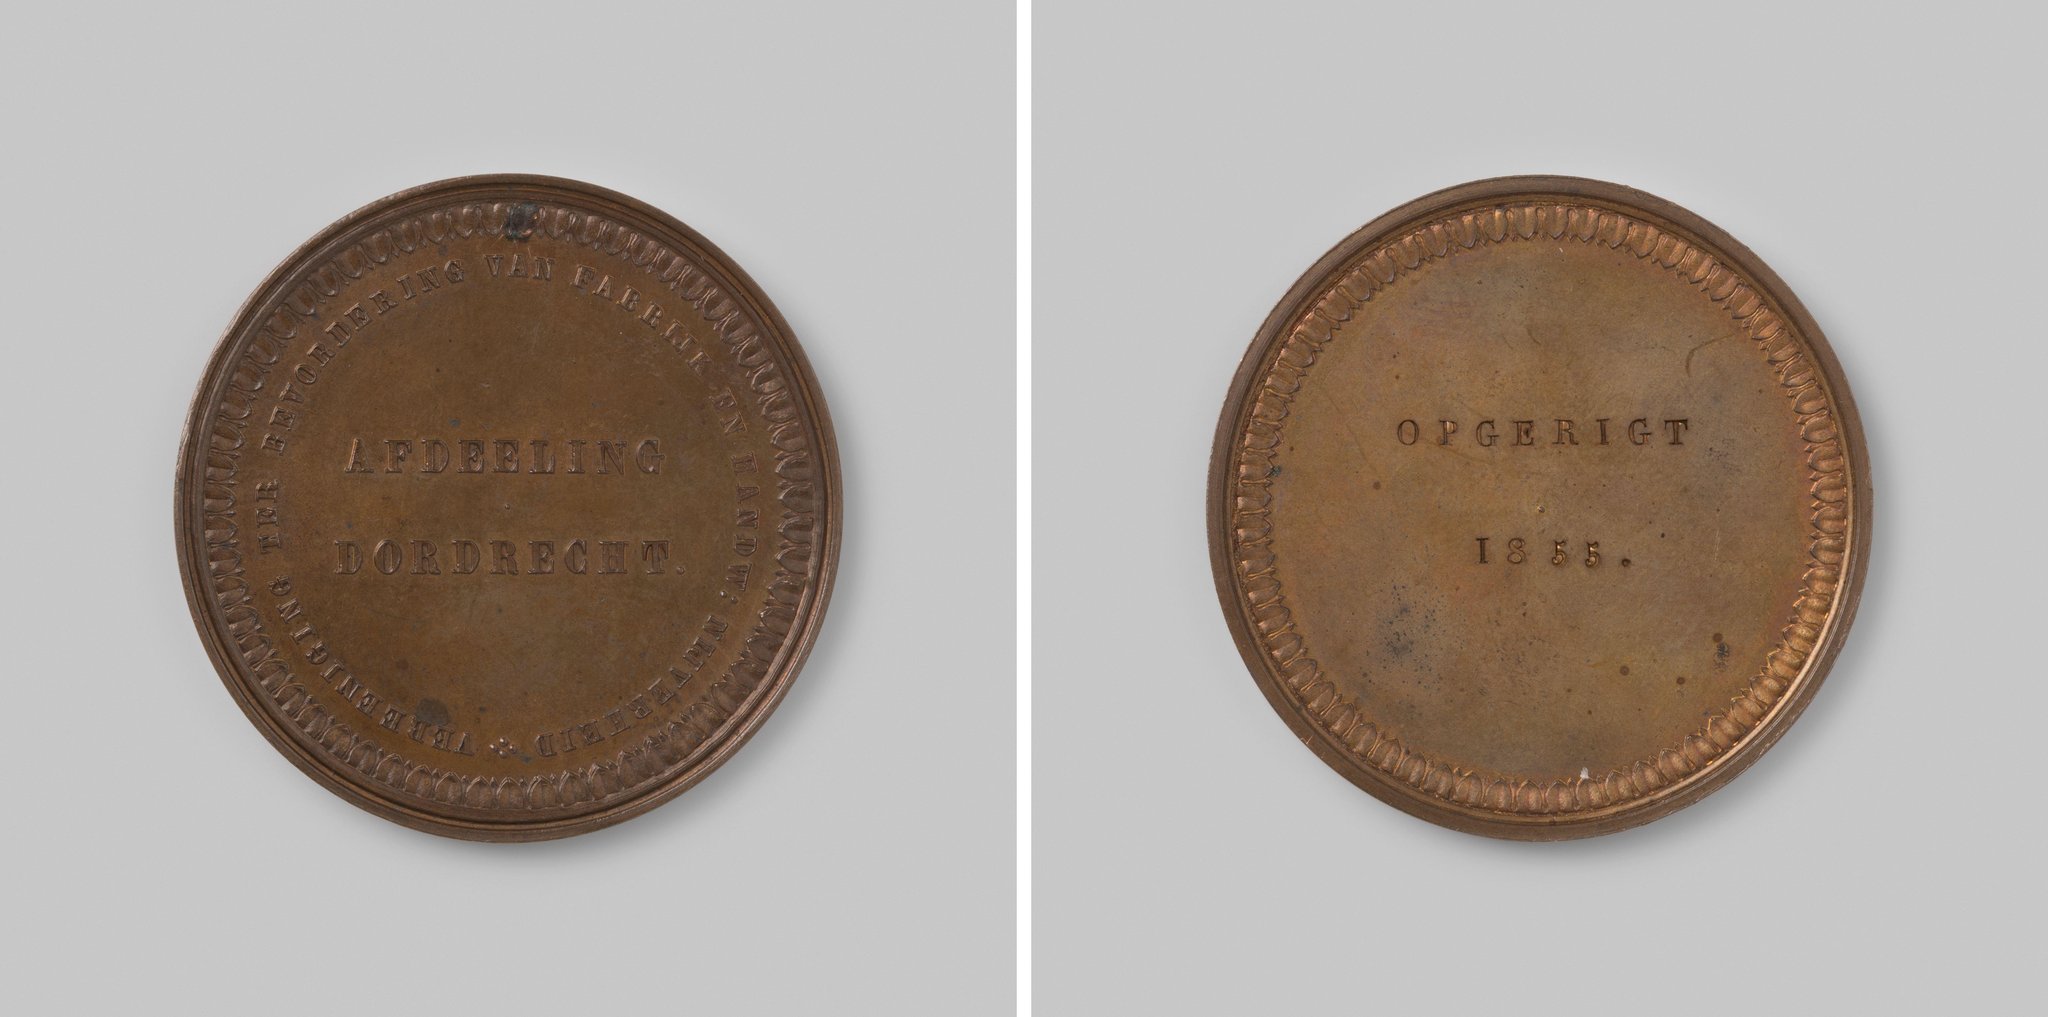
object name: medal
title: Afdeling Dordrecht van de Vereeniging ter bevordering van Fabrijk- en Handwerksnijverheid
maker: Anonymous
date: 1855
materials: bronze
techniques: engraving, striking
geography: netherlands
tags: dordrecht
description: Bronzen penning. Voorzijde: opschrift binnen omschrift en sierrand. Keerzijde: opschrift binnen omschrift.